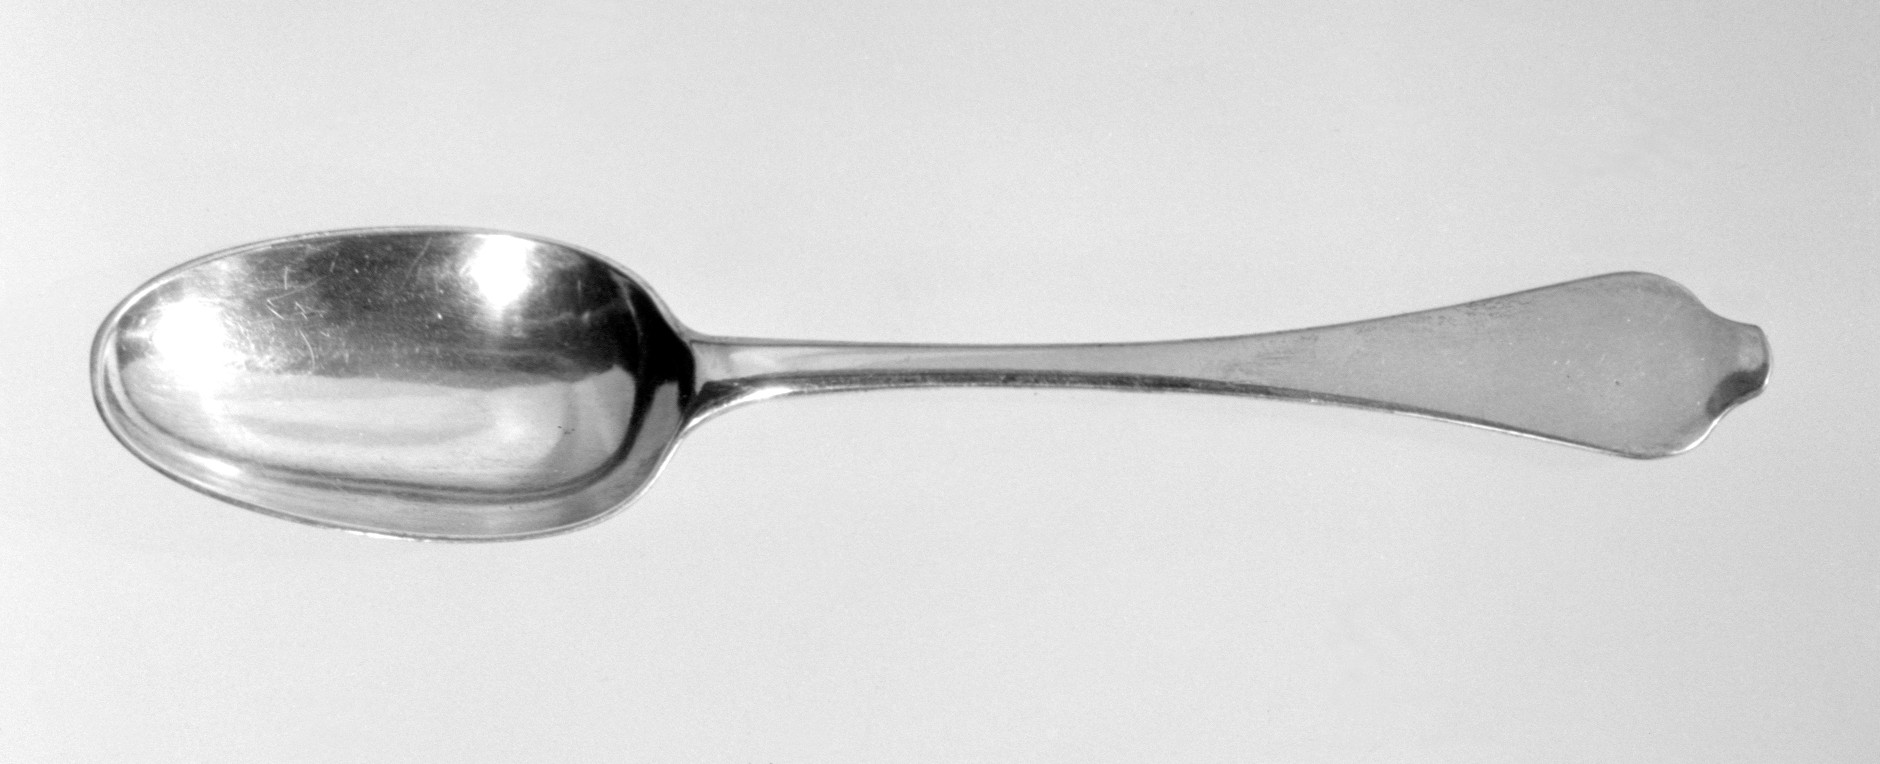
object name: spoon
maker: thomas sadler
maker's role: maker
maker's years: 1701-1720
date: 1705-1706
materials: silver